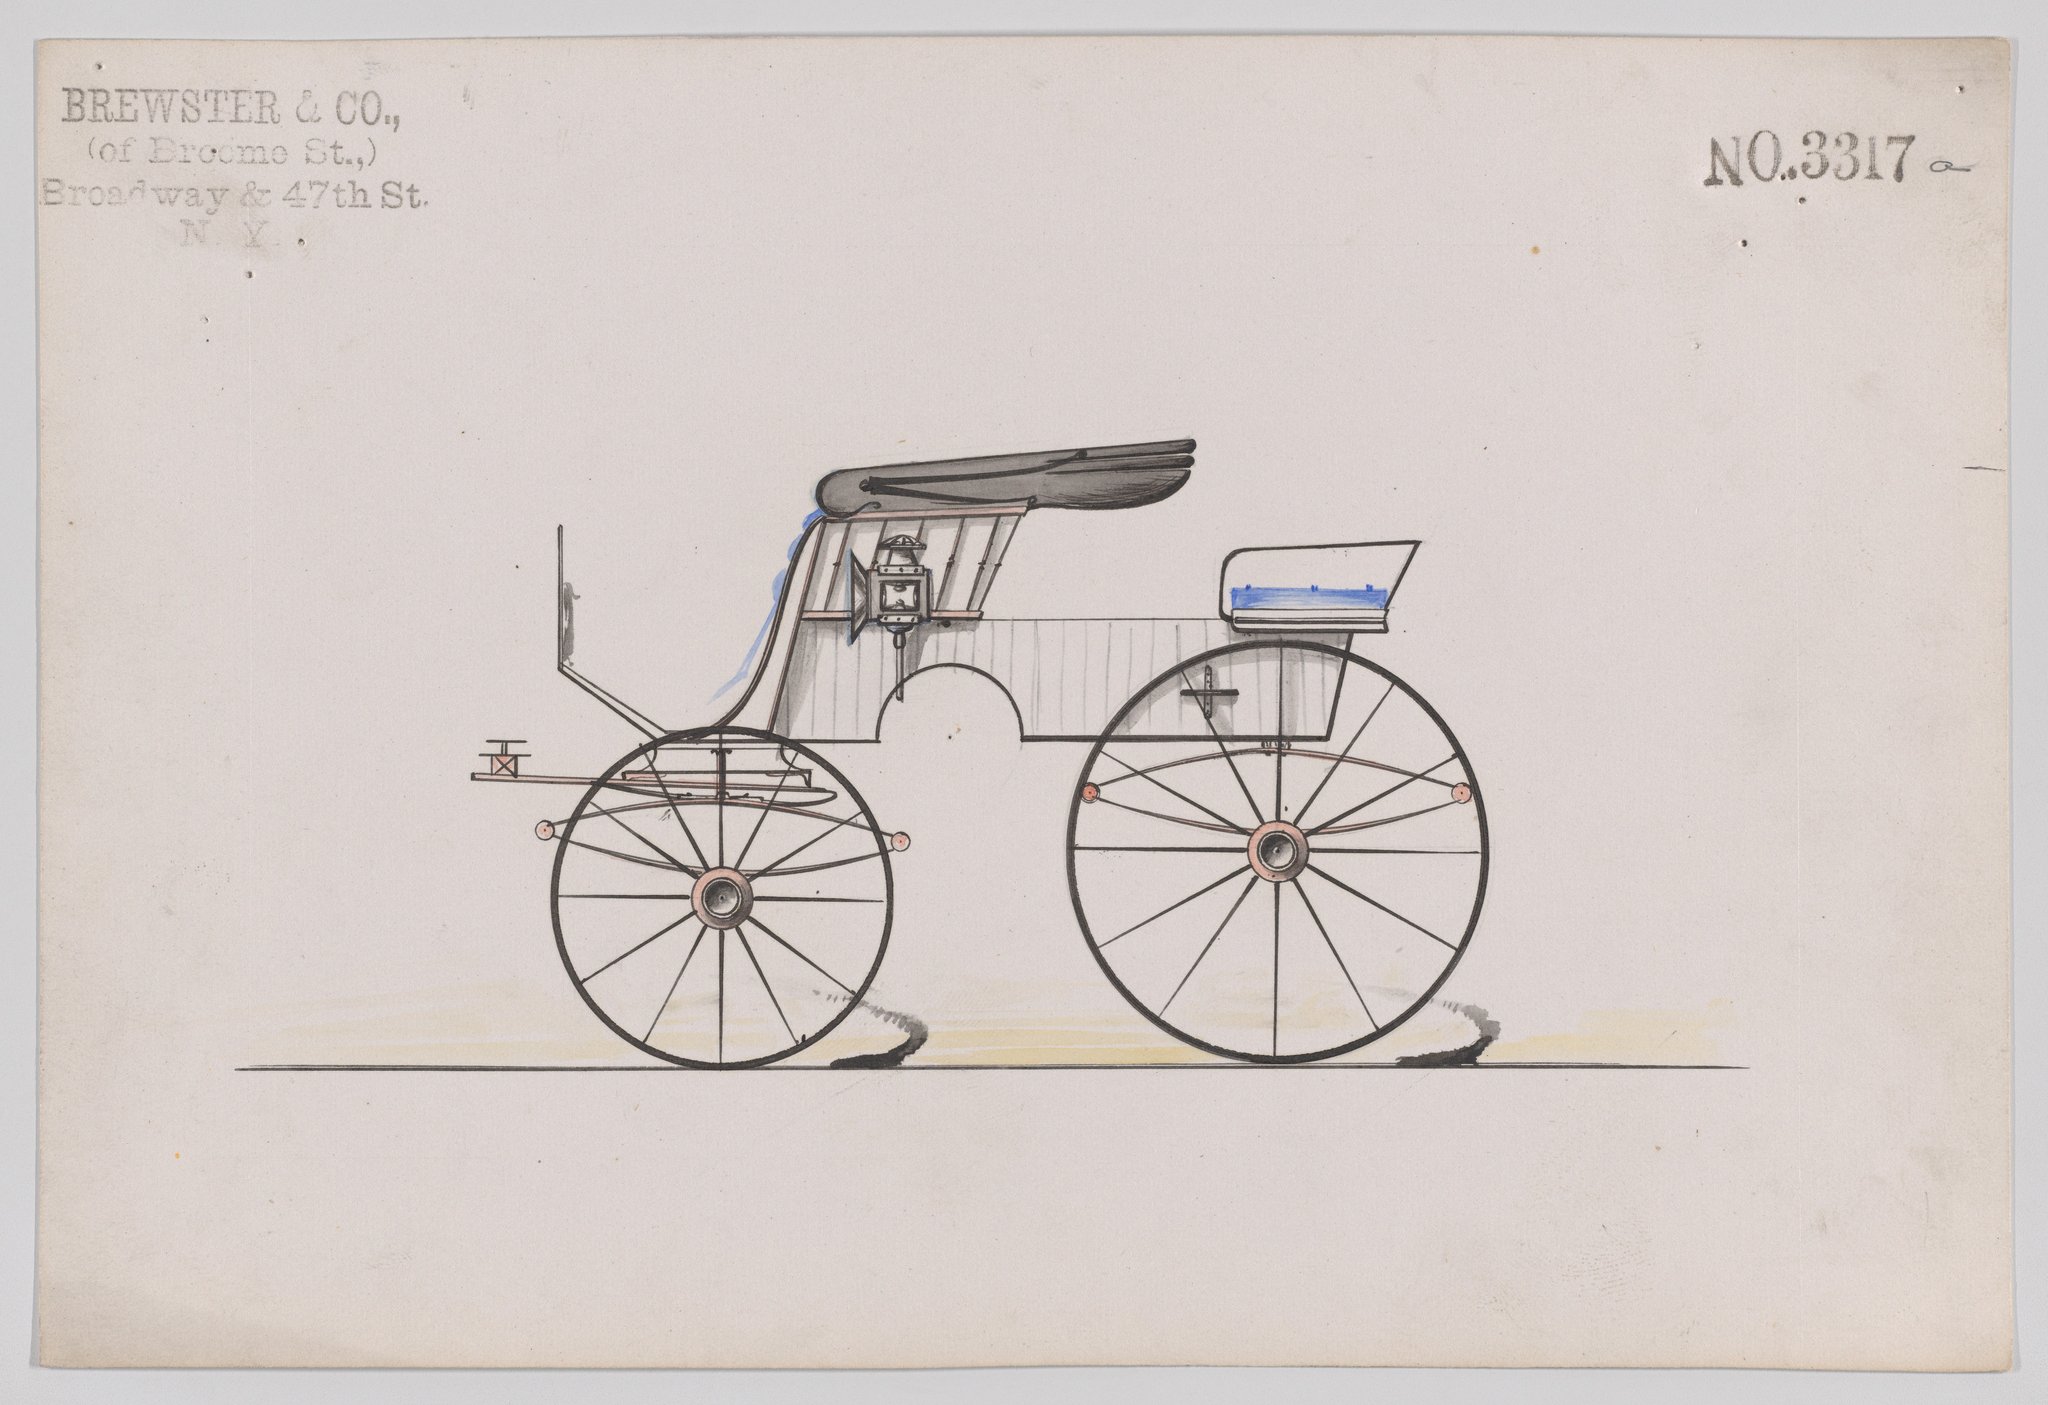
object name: drawing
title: Design for Stanhope Phaeton, no. 3317a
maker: brewster & co.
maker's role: manufacturer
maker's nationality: american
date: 1877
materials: gouache, ink, watercolor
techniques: pen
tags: carriages